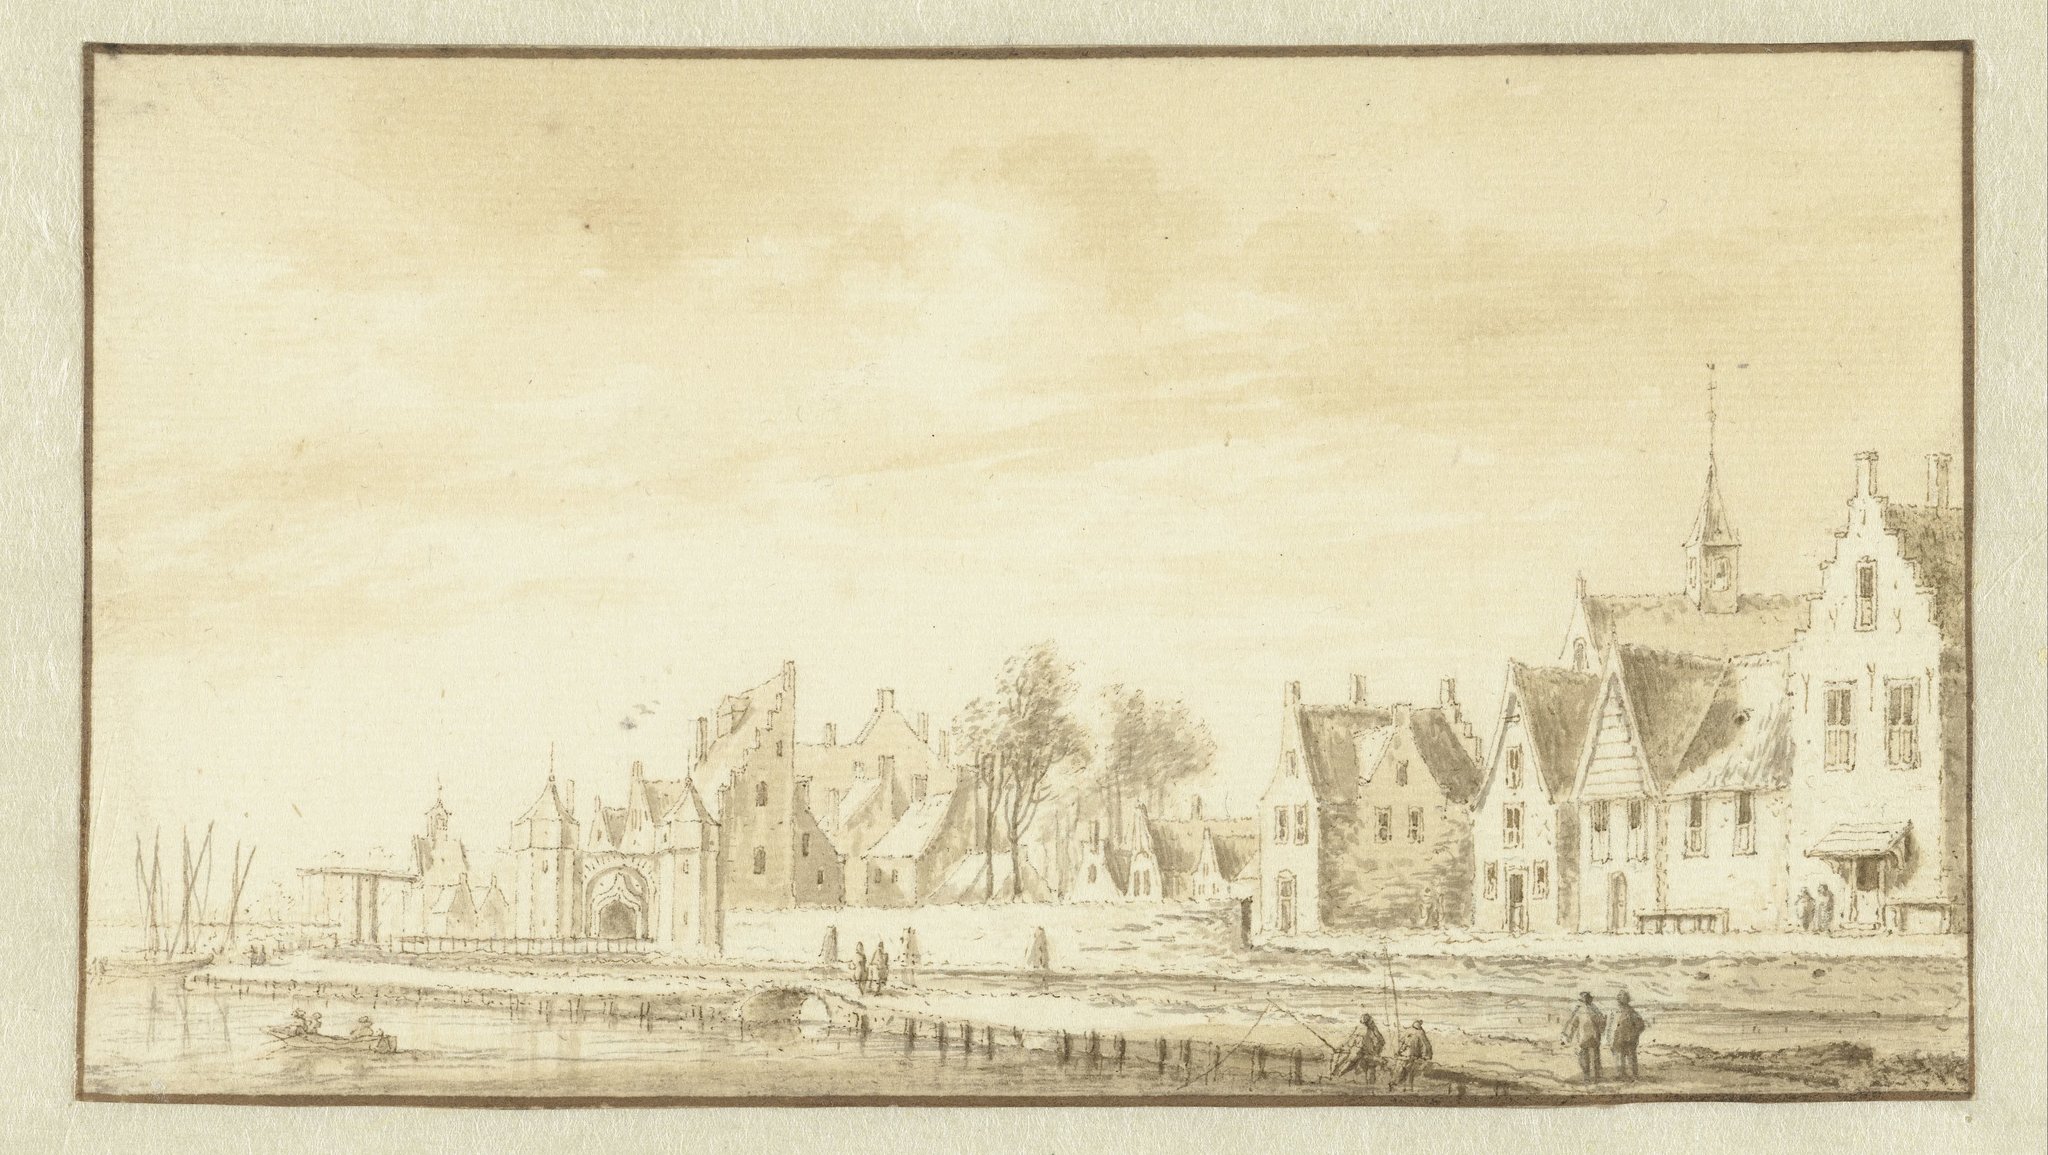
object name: drawing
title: Gezicht op Montfoort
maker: abraham rademaker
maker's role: draughtsman, print maker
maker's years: 1676-1735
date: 1685-1735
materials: ink, paper, pencil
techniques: brush, pen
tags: prospect of village, silhouette of village